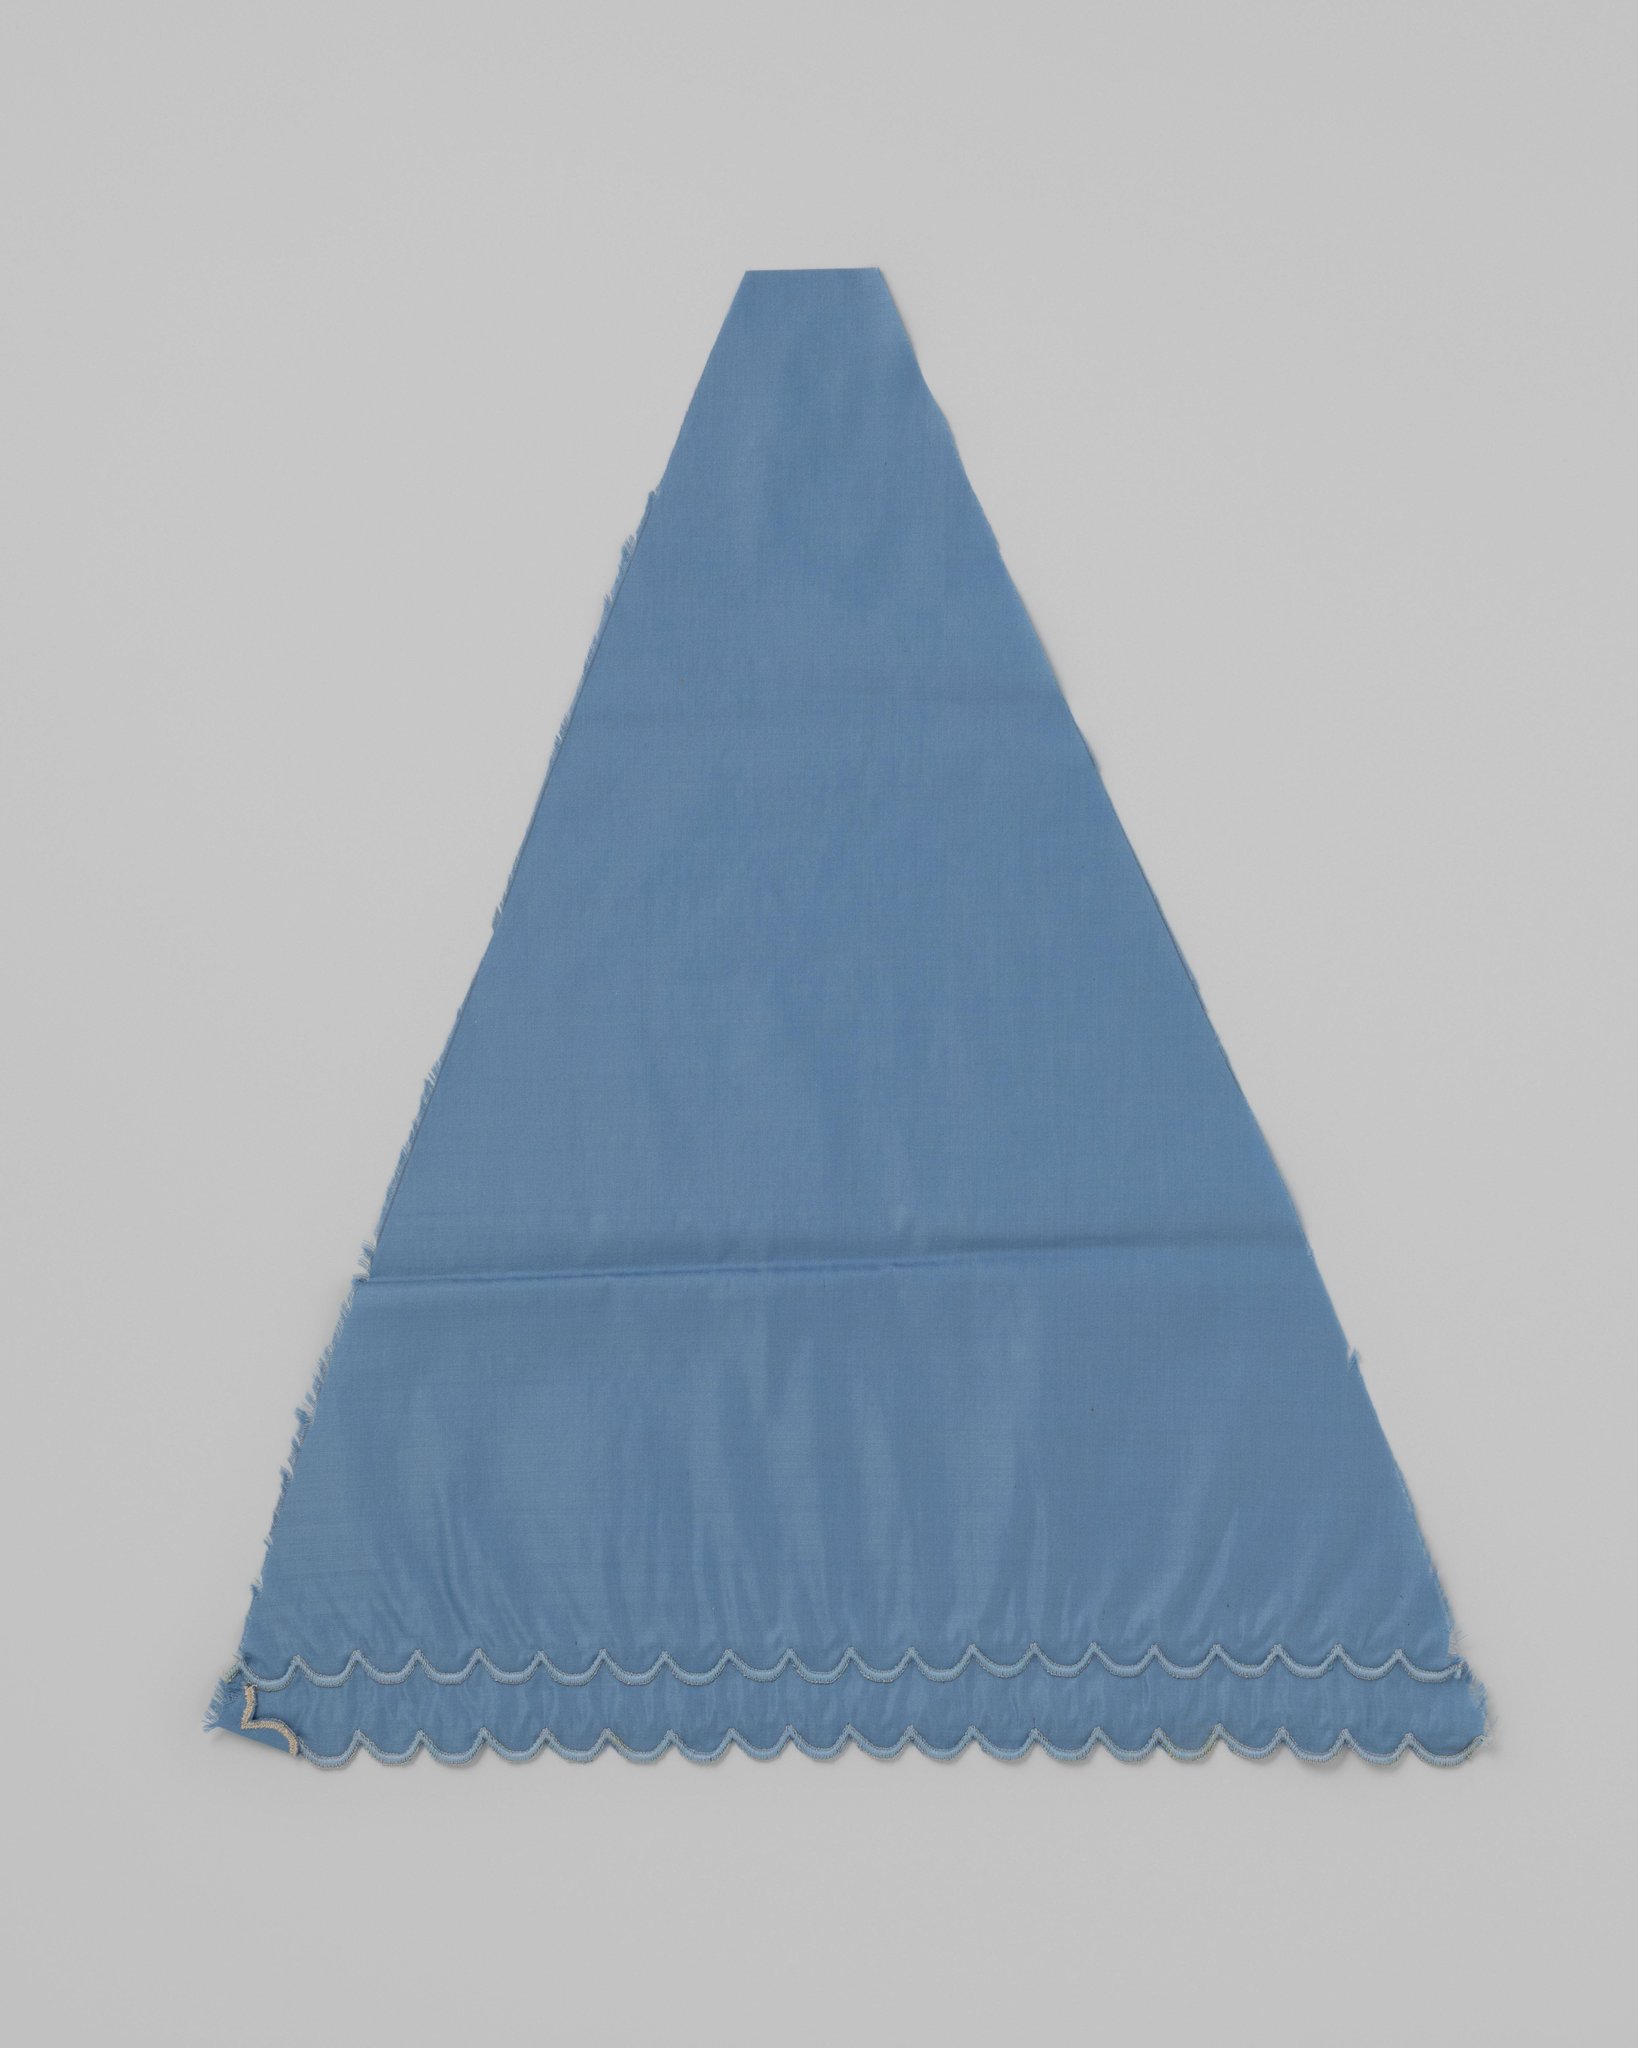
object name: parasoldek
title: Sector van een parasoldek van lichtblauw katoen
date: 1885-1900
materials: cotton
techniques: festoon stitch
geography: france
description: Sector van een parasoldek van lichtblauw katoen. Met een dubbele rij gefestonneerde schulpen.